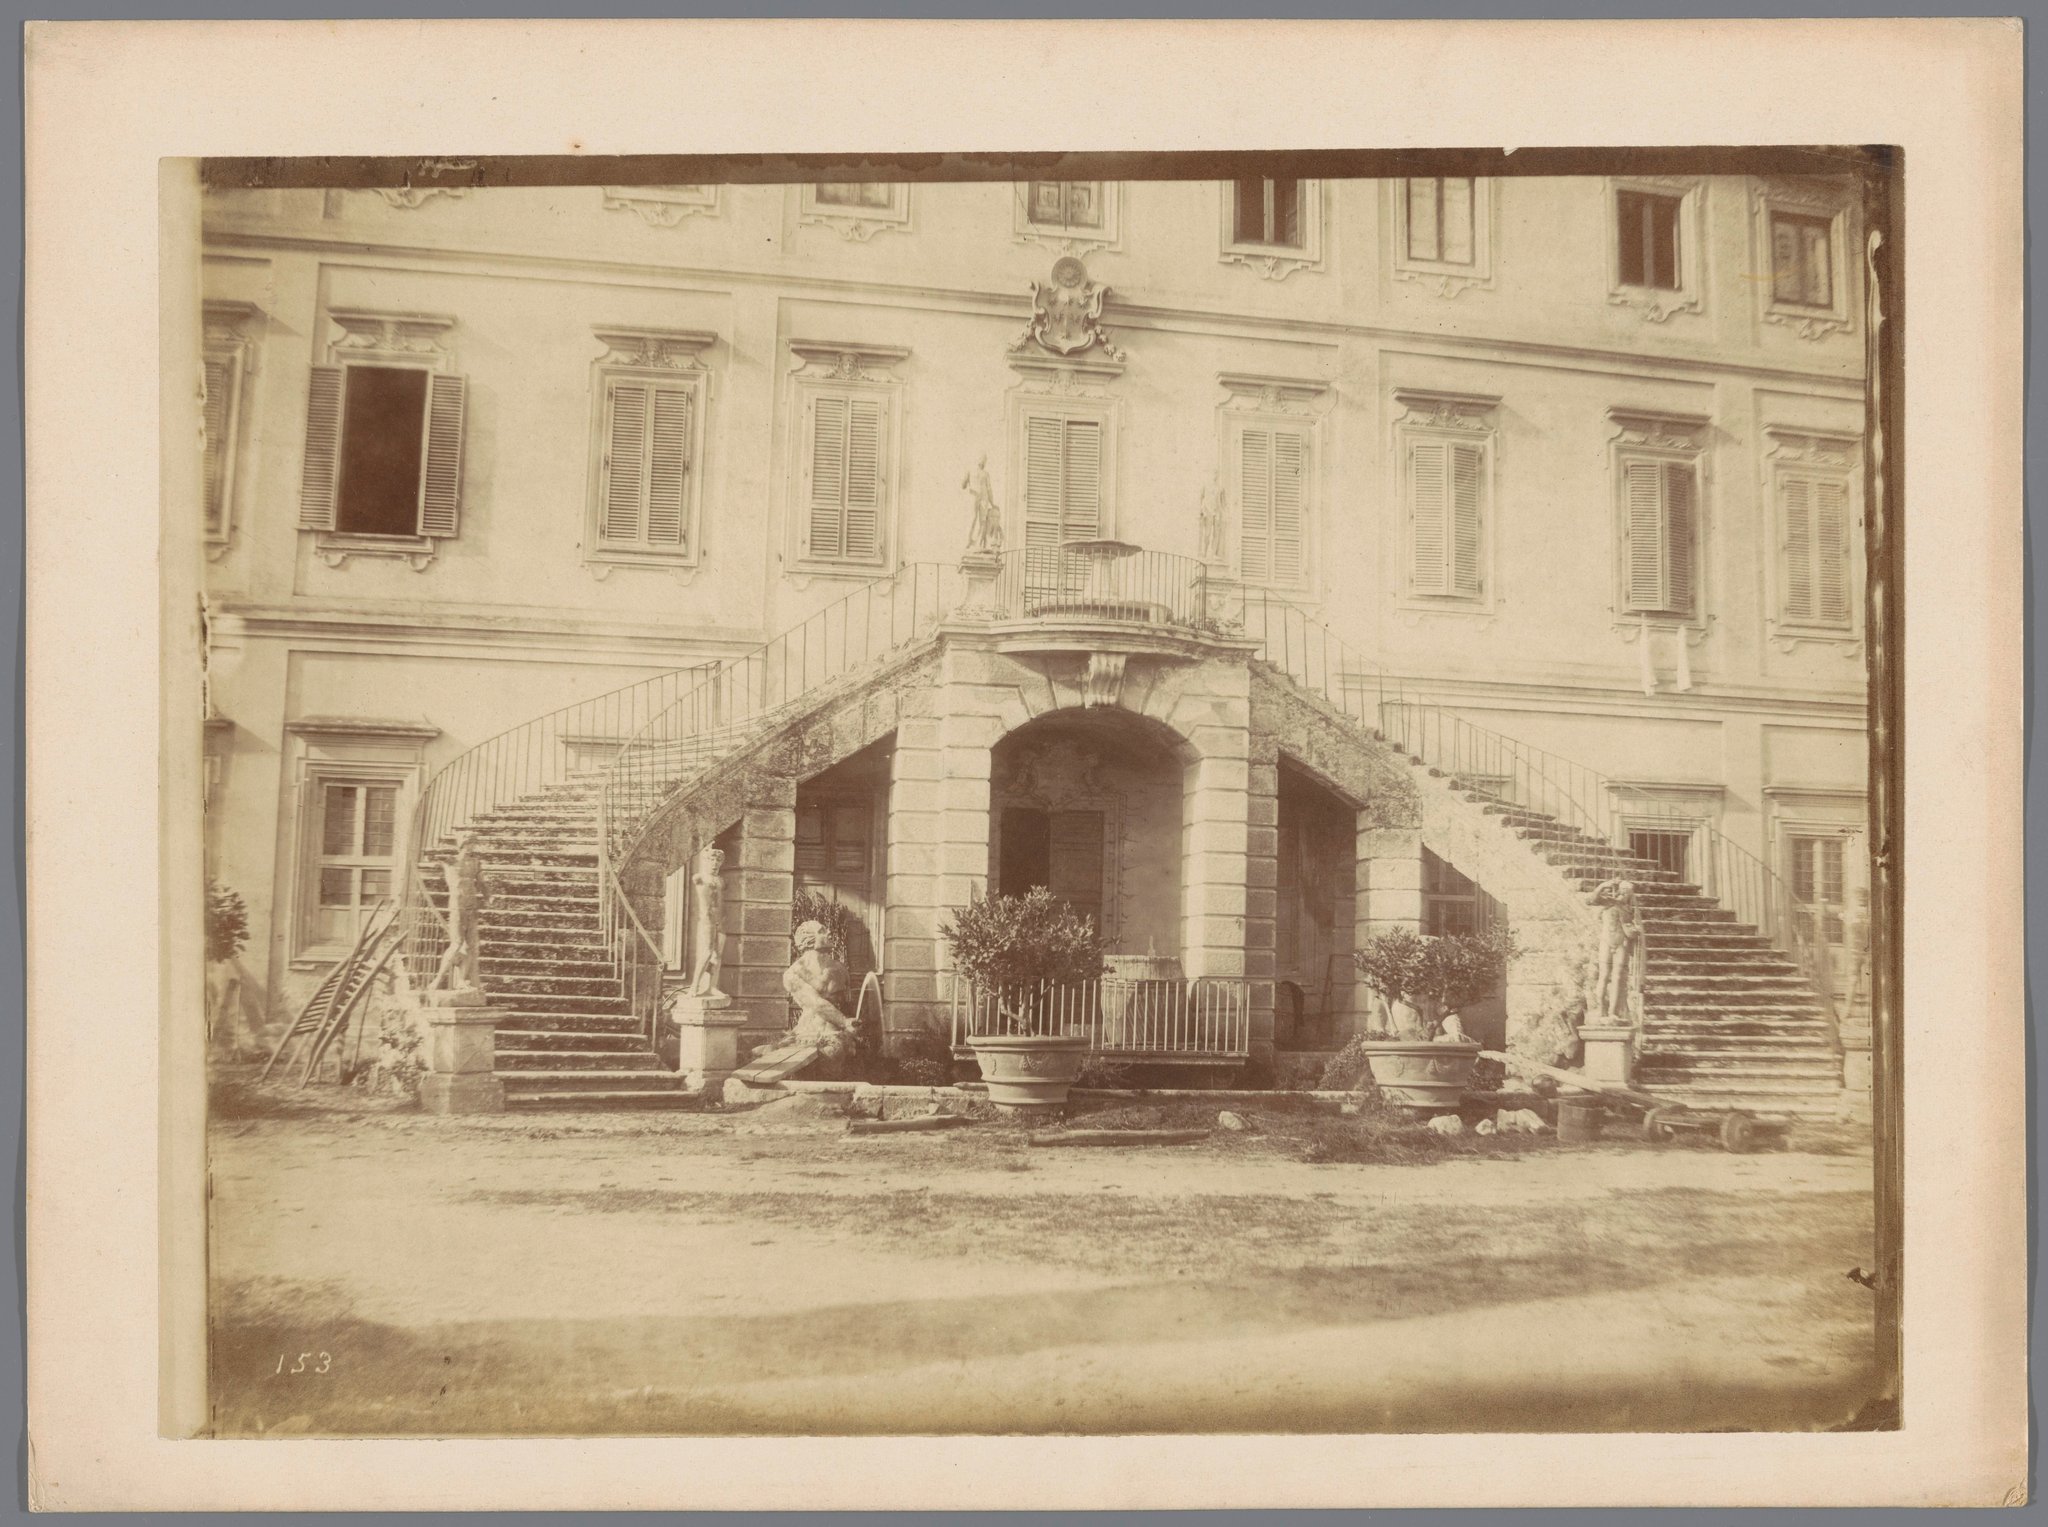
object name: photograph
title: Trappen voor een villa te Italië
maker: gustave eugène chauffourier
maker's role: fotograaf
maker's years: 1845-1919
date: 1875-1900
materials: photographic support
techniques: albumen print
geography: rome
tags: villa, staircase, façade (of house or building), rome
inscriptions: collector's mark: Lugt 3937, number: ‘153’